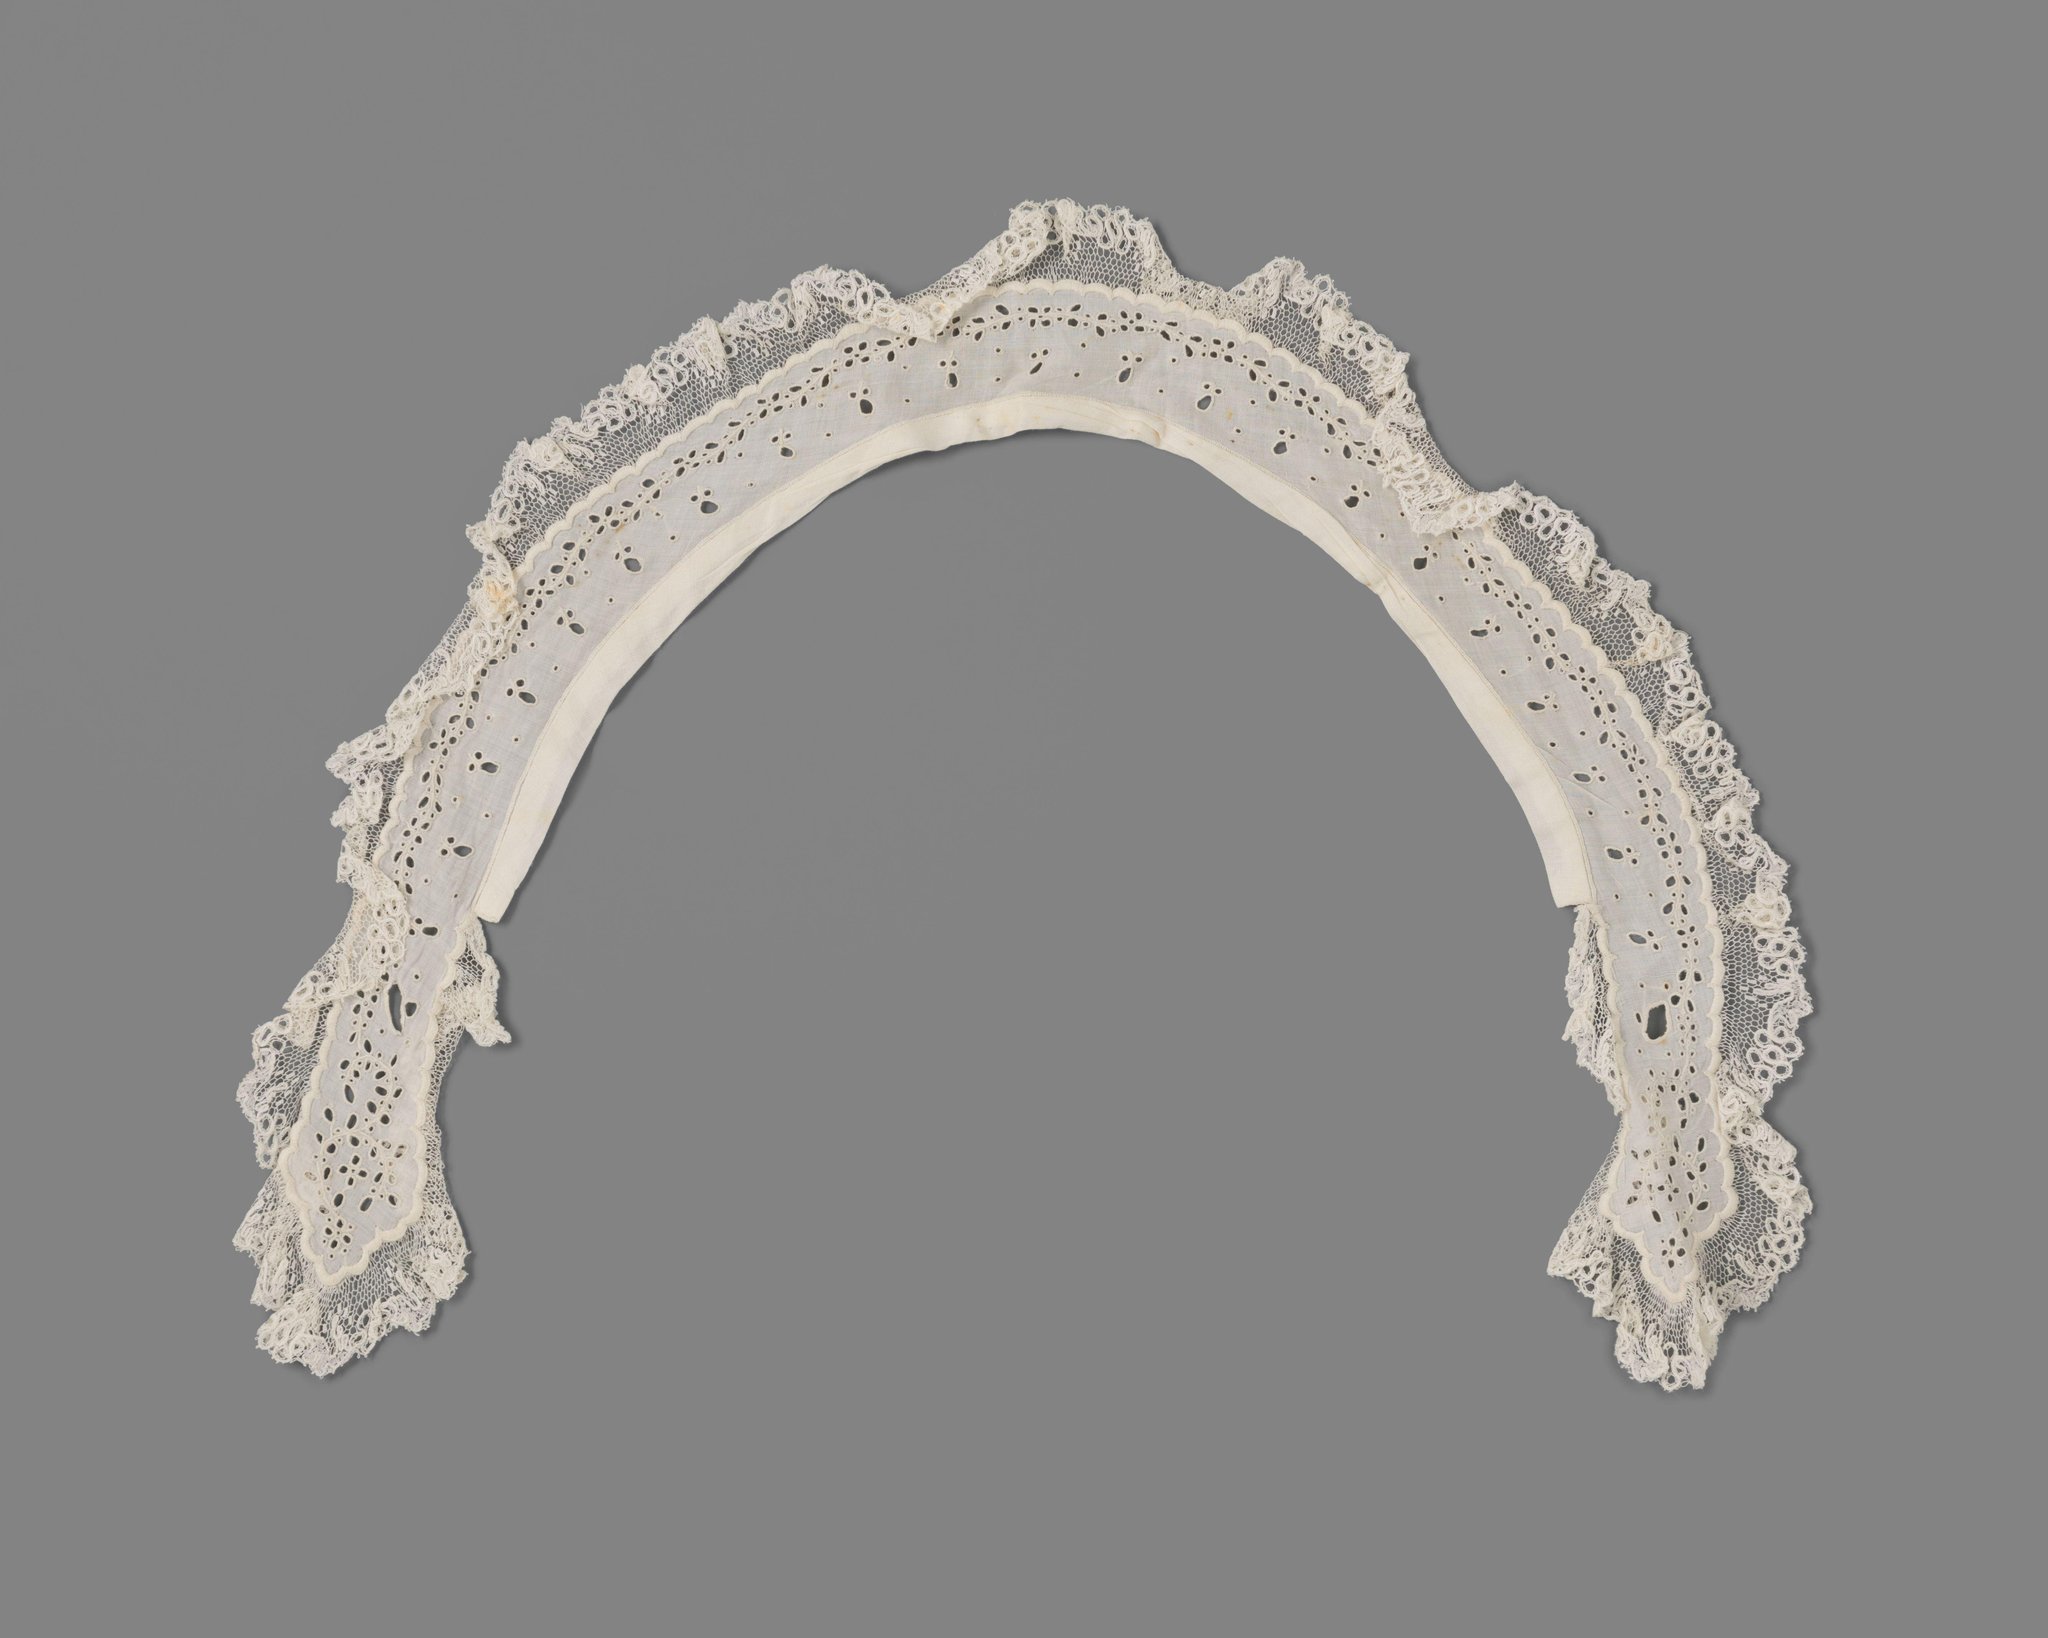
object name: womenswear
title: Kraag van katoen, nauwsluitend om de hals, versierd met floraal Engels borduurwerk en Rijsselse kant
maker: Anonymous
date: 1875-1900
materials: cotton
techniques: lace, weave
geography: netherlands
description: Kraag van katoen, nauwsluitend om de hals, versierd met floraal Engels borduurwerk en Rijsselse kant.